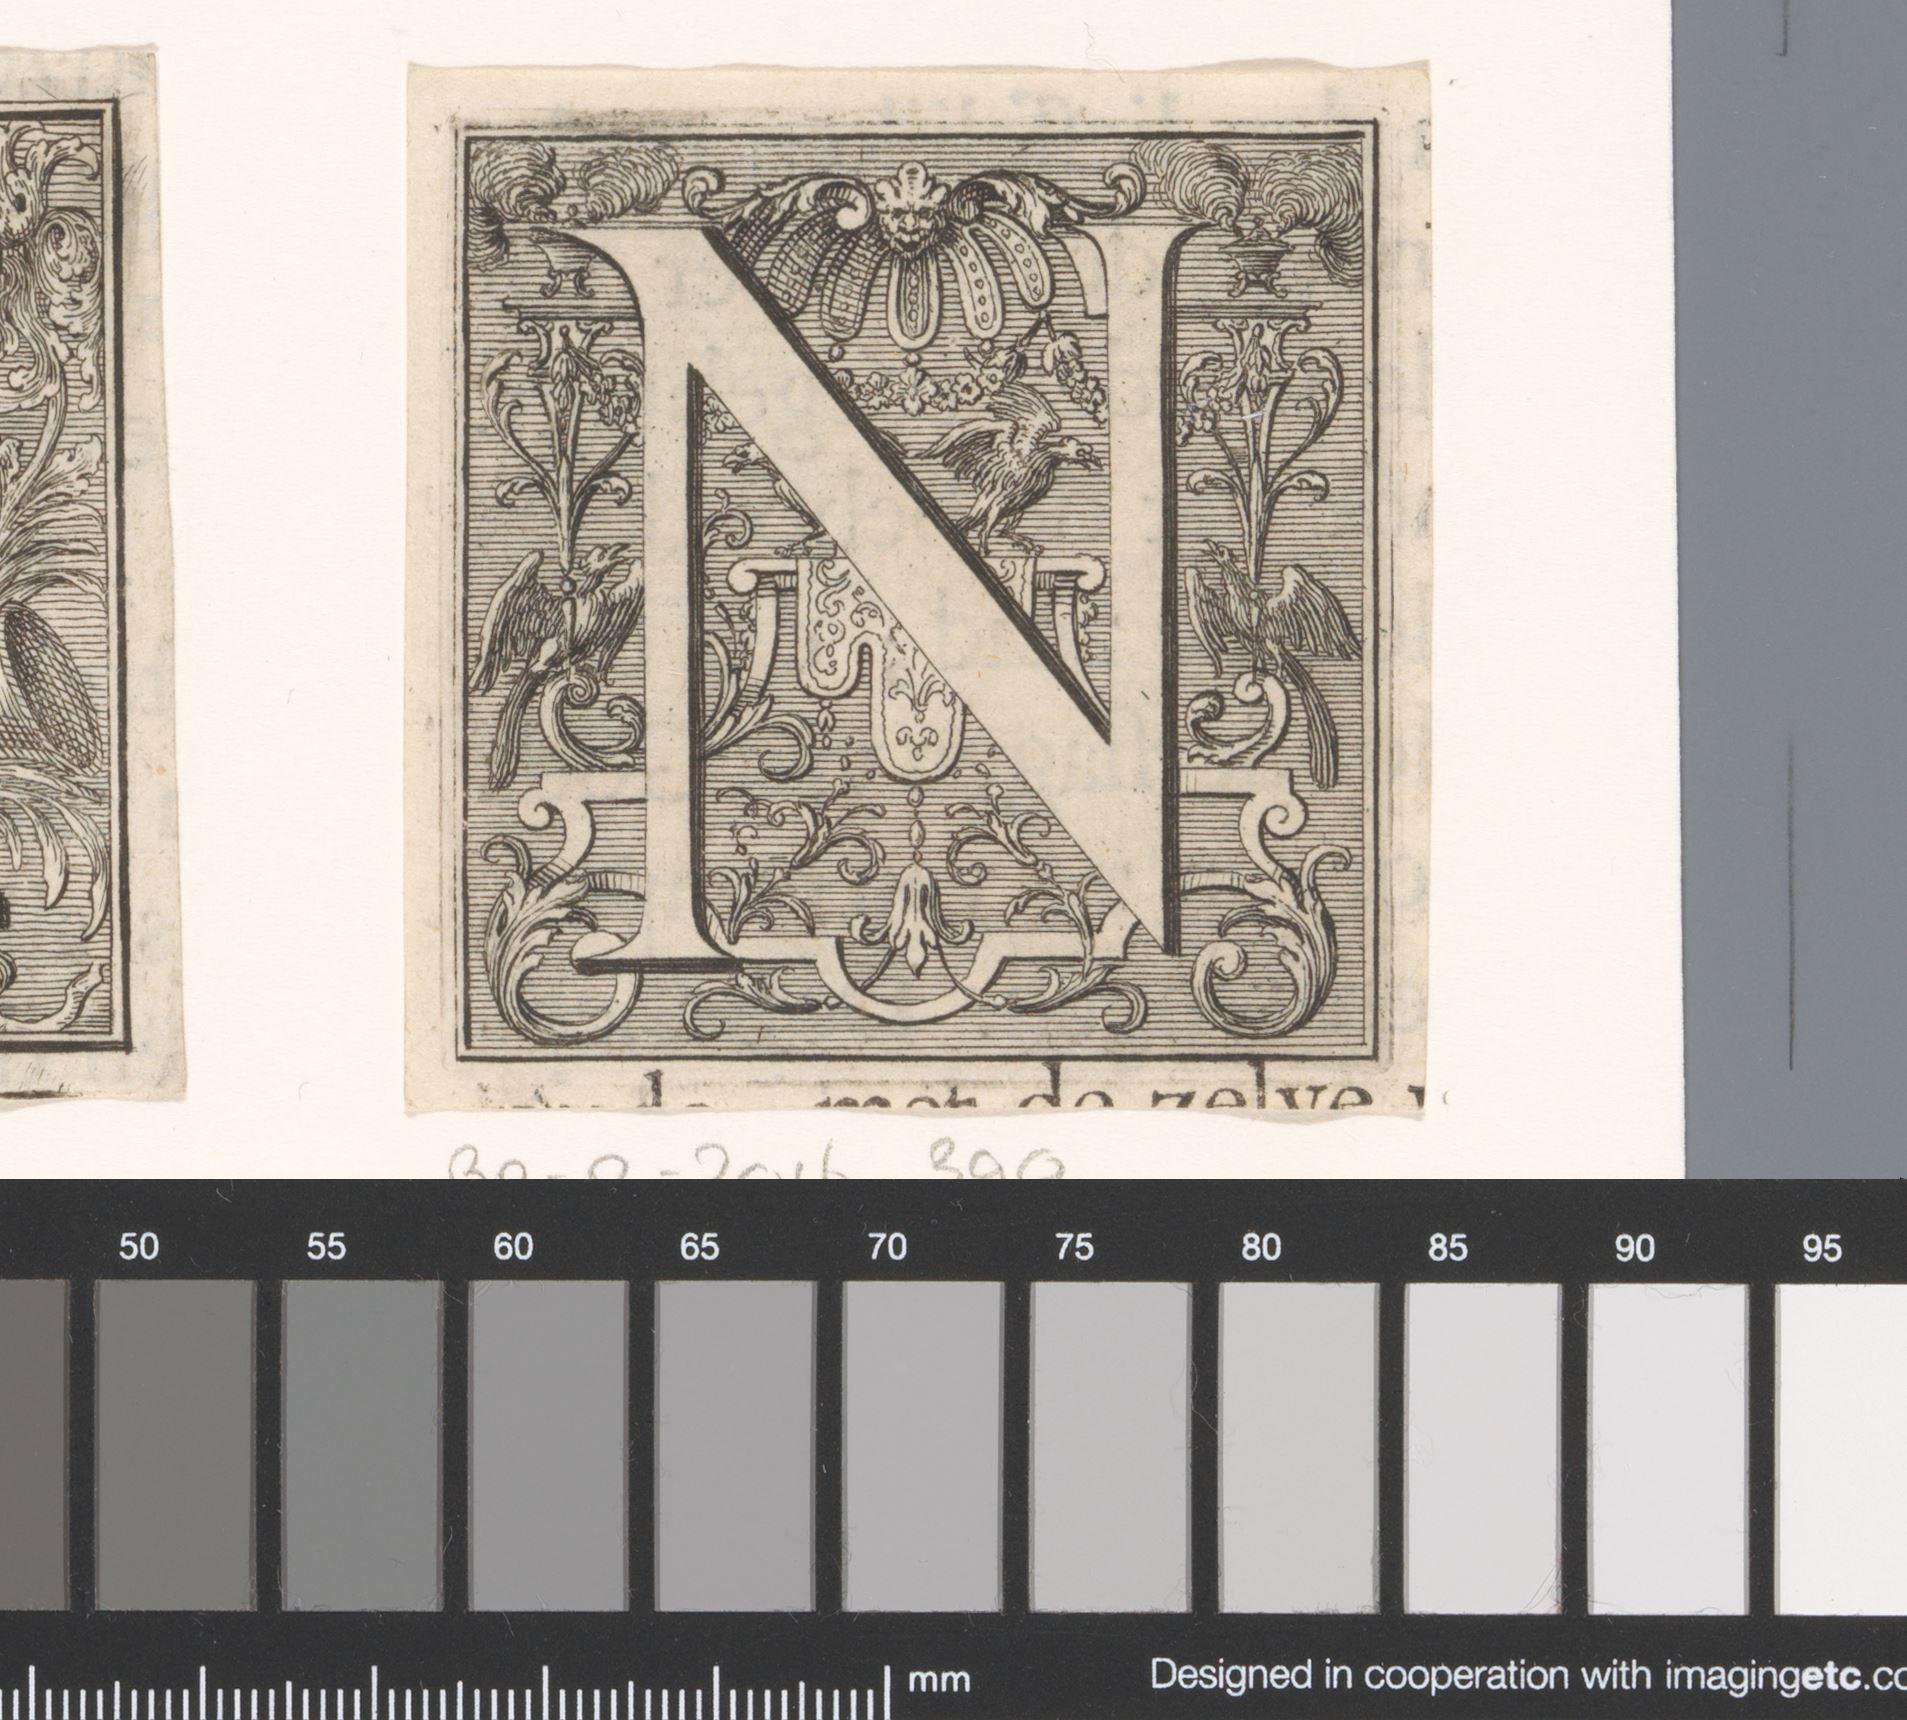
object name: print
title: Letter N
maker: Anonymous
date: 1700-1799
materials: paper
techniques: etching, letterpress printing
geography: netherlands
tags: fancy letters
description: Letter N tegen een achtergrond met vlechtwerk, rookvaten en vogels.